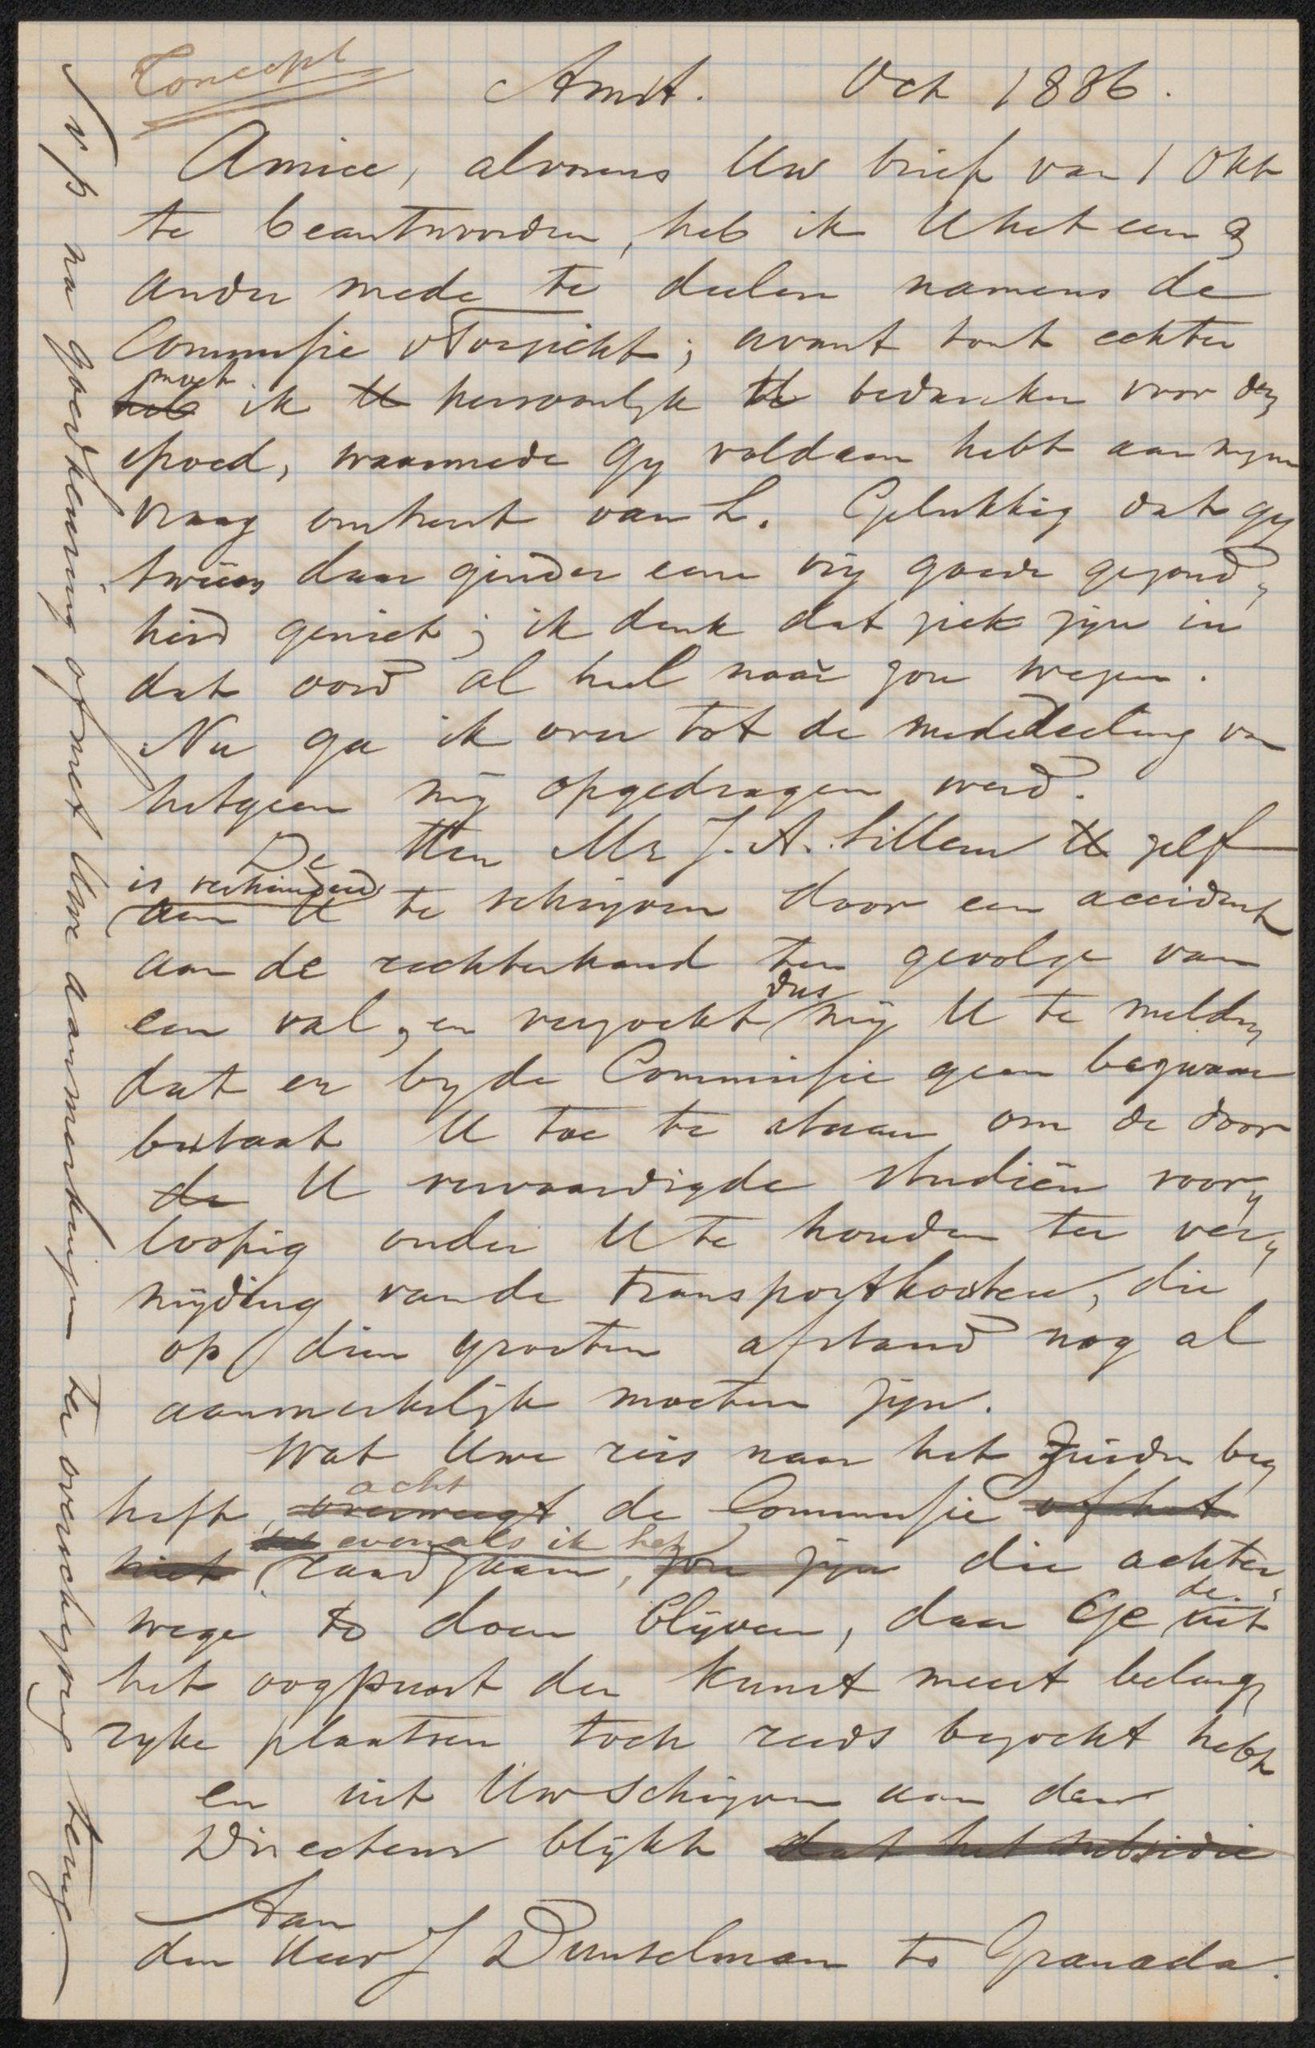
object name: letter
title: Conceptbrief aan Jan Dunselman en conceptbrief aan anoniem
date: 1810-1886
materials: ink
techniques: pen, writing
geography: amsterdam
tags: haarlem, painter, print maker, draughtsman, jac van looij, den helder, jan dunselman, travelling; tourism, education, tuition of the artist (in general), diseases, money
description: Brief bevat aantekening van Jérôme Alexander Sillem.